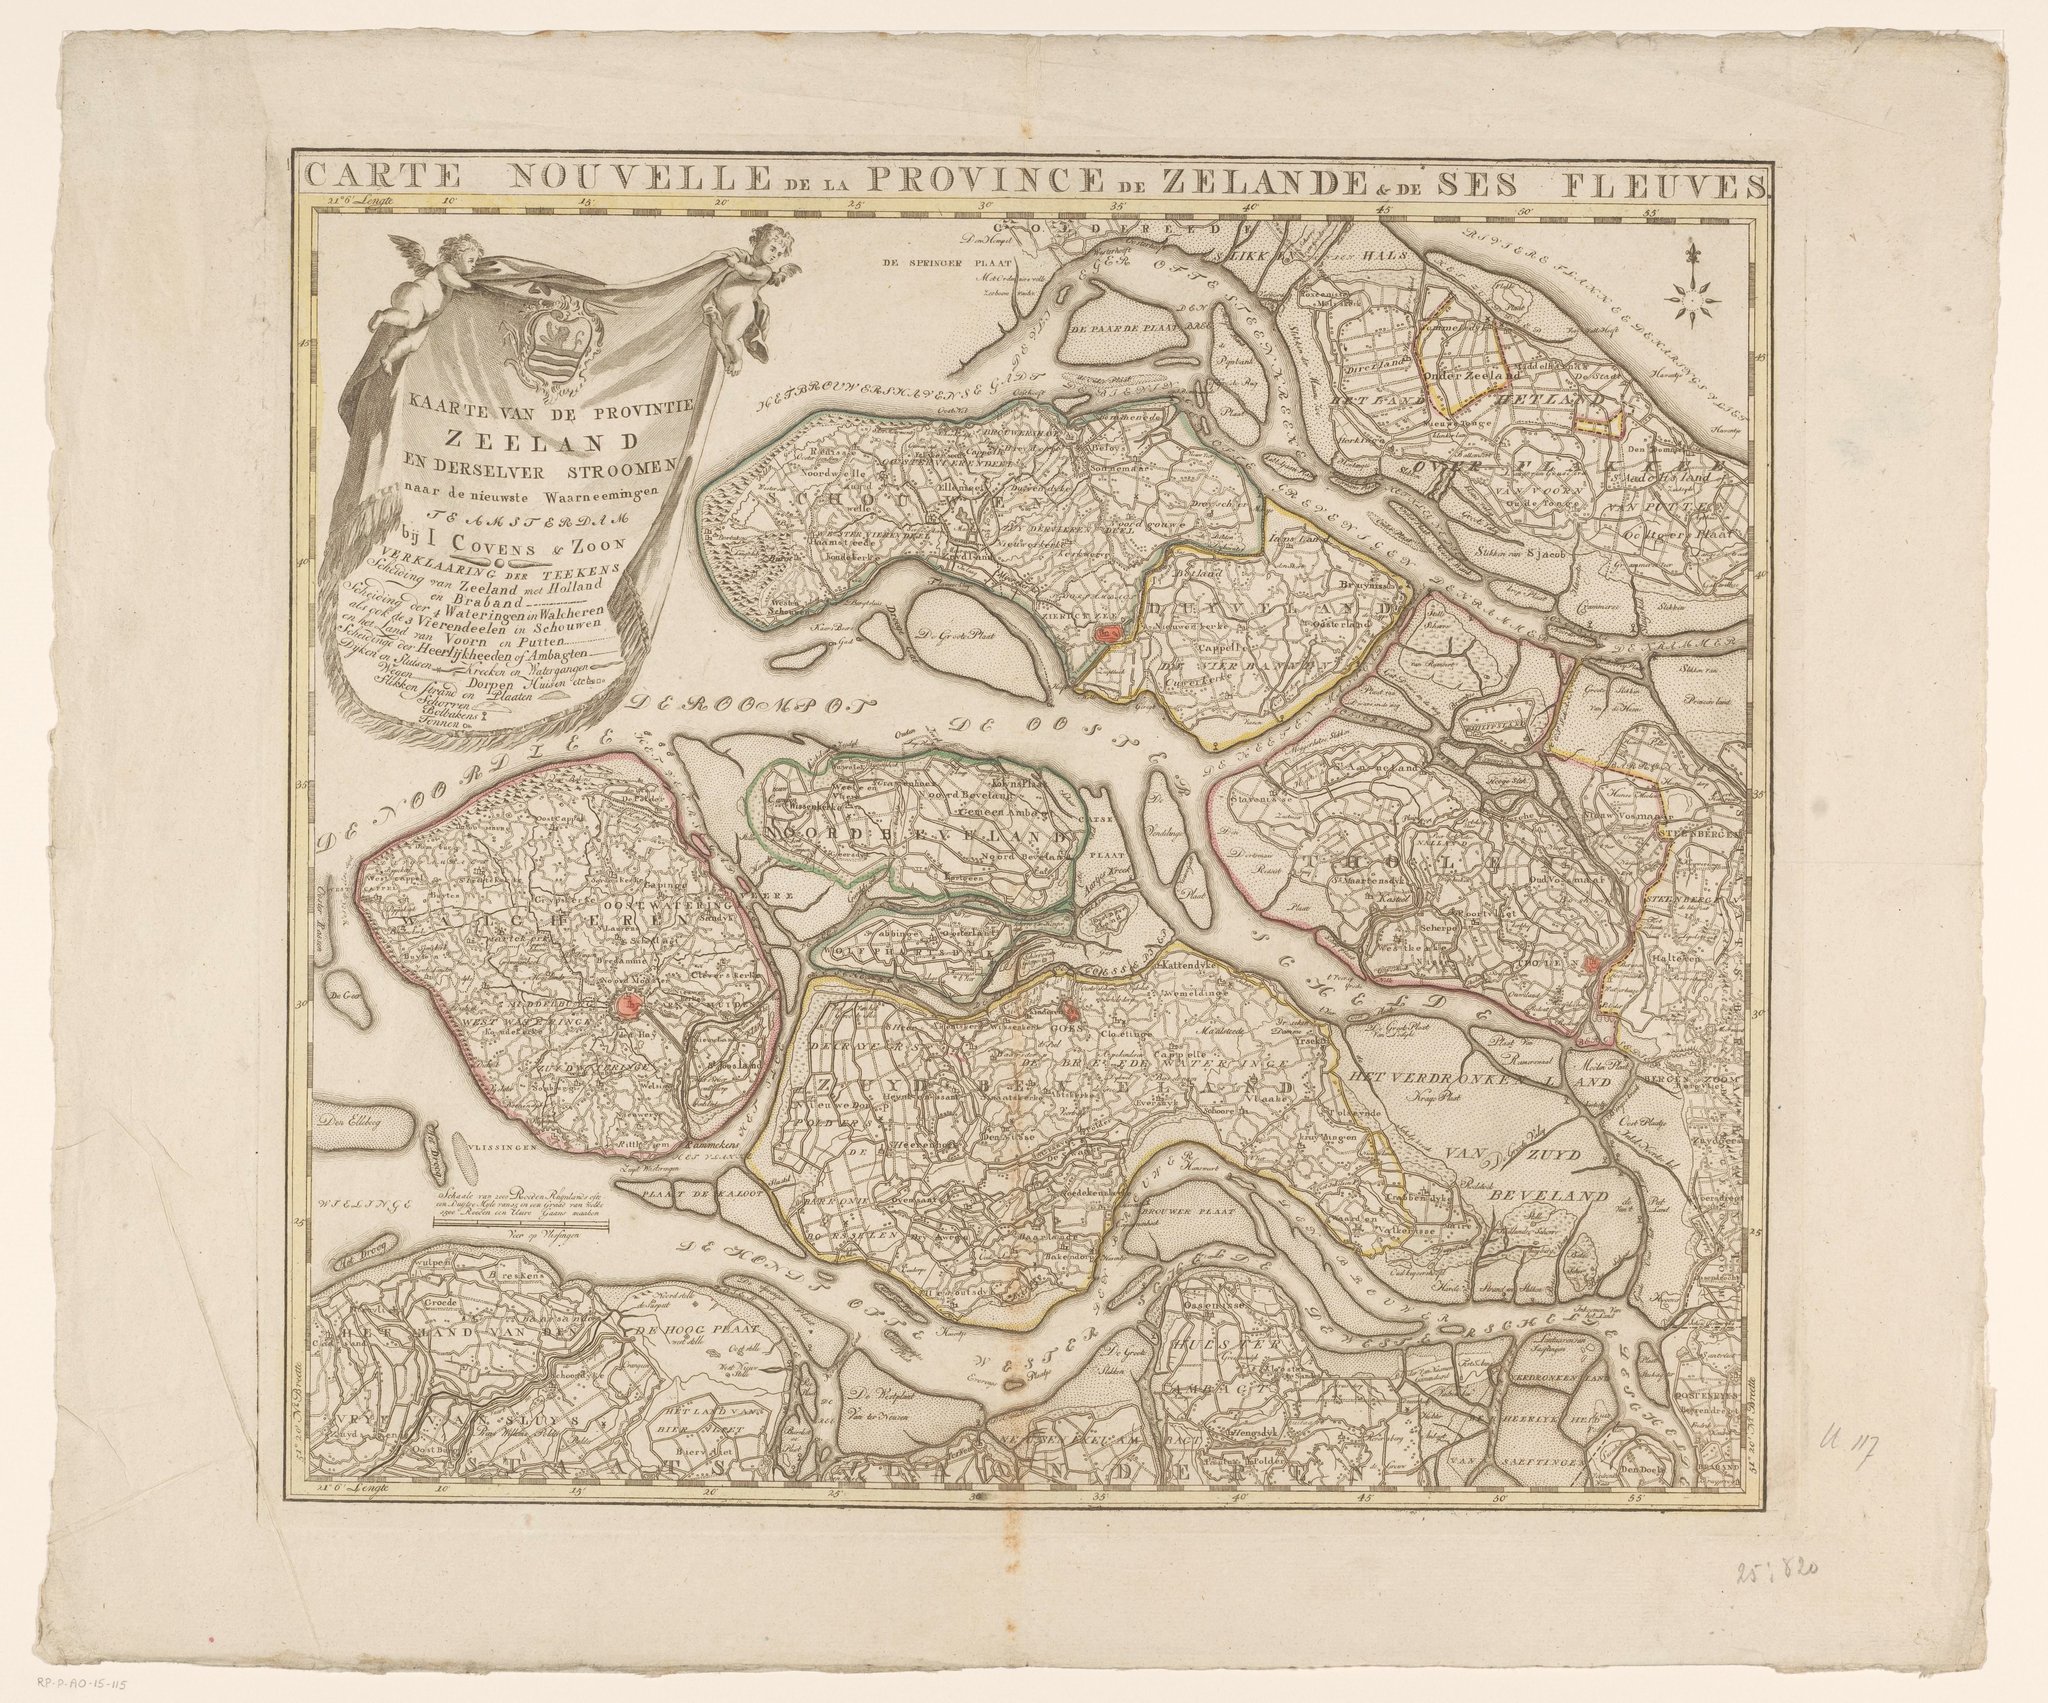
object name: print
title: Kaart van Zeeland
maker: Anonymous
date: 1787-1792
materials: paper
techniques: engraving, etching, hand coloring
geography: amsterdam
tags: maps of separate countries or regions, coat of arms (as symbol of the state, etc.) (+ province; provincial), zeeland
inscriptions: collector's mark: Lugt 19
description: Langs de bovenkant de Franse titel. Linksboven een cartouche met de Nederlandse titel, het wapen van Zeeland en de legenda. Linksonder, boven Zeeuws-Vlaanderen, een schaalstok: Schaale van 2000 roeden Rhijnlands ofte een Duijtse myle van 15 in een graad van welke 1500 roeden een uure gaans maaken. Gradenverdeling langs de randen.